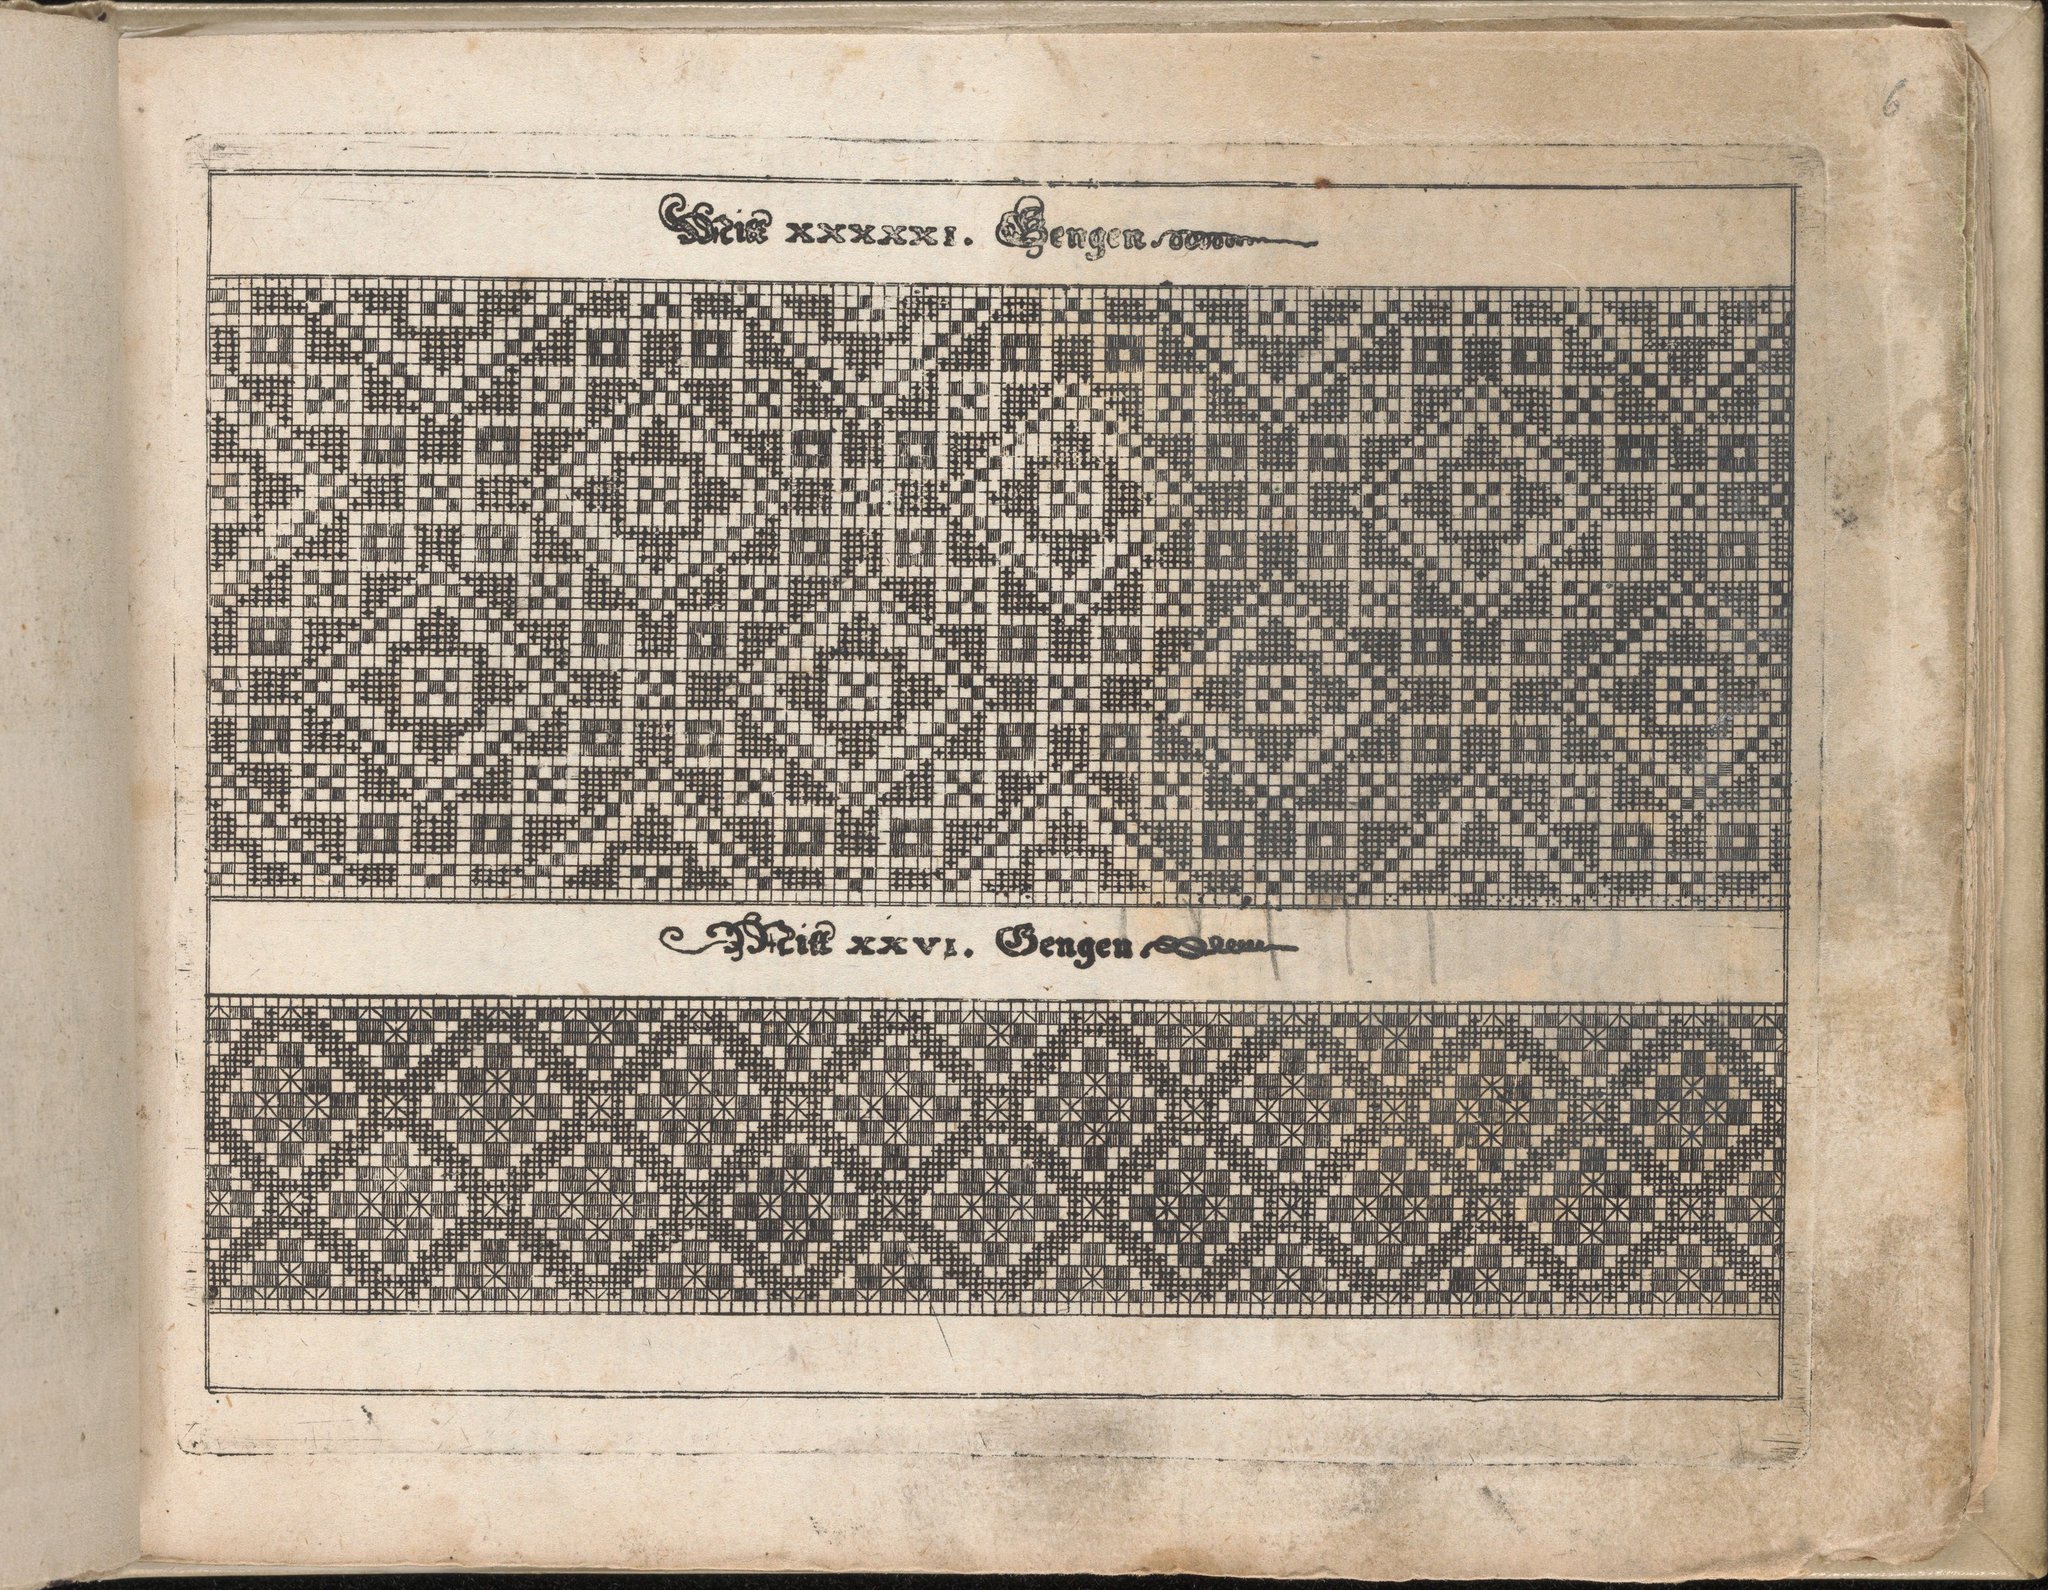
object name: book print ornament architecture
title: Schön Neues Modelbuch (Page 11 recto)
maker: johann sibmacher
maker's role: designer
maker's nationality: german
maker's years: 1590-1611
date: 1597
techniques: etching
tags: ornament